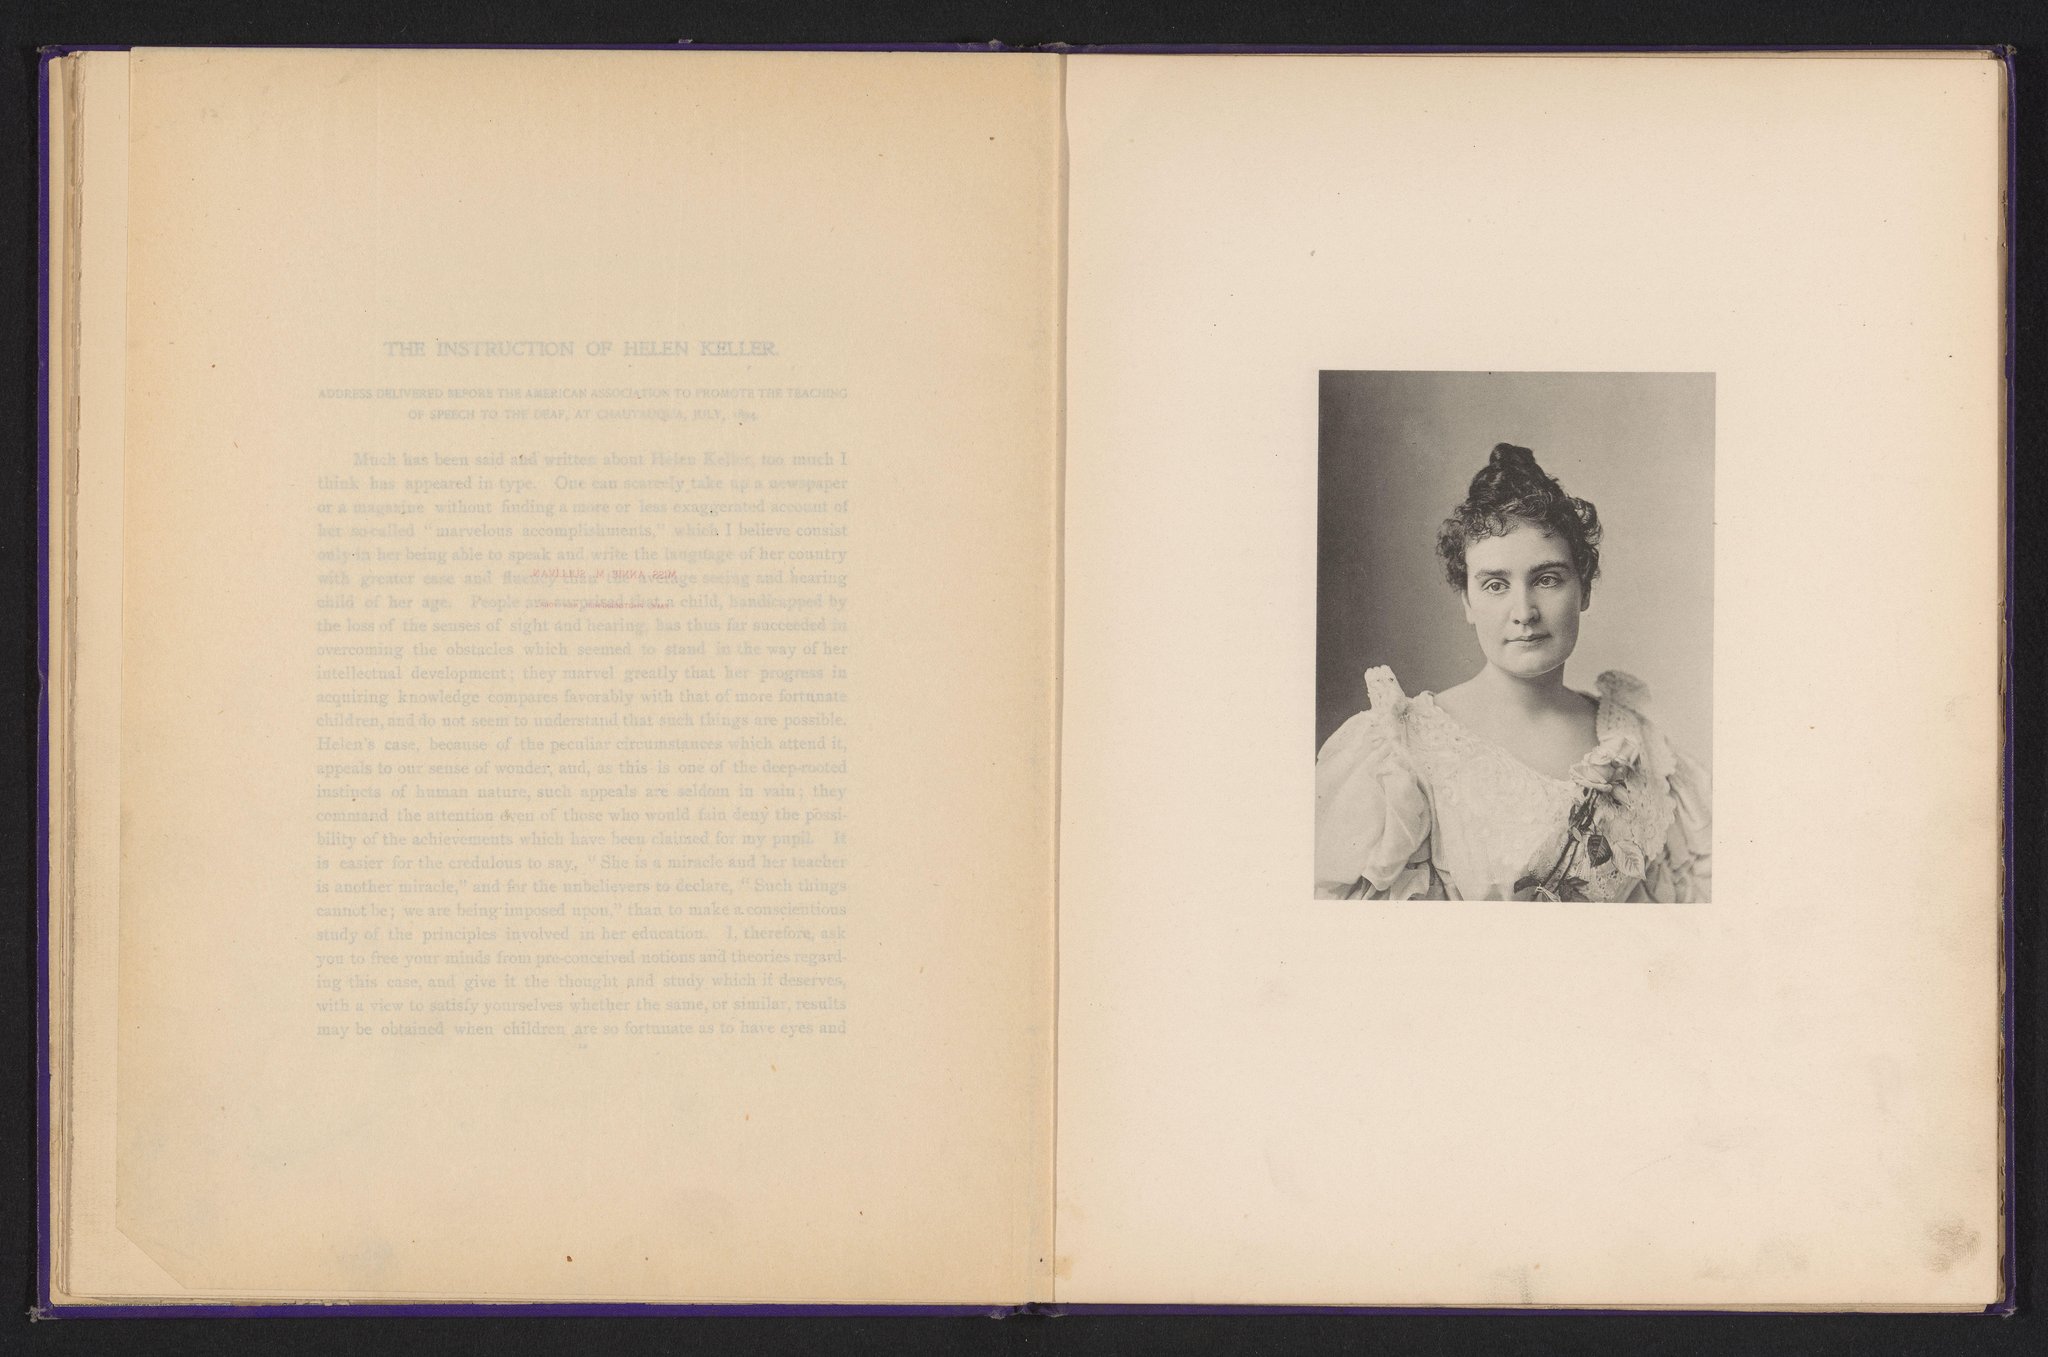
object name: page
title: Portret van Anne Sullivan, de docent van Helen Keller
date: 1885-1895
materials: paper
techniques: photograph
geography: new york city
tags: adult woman